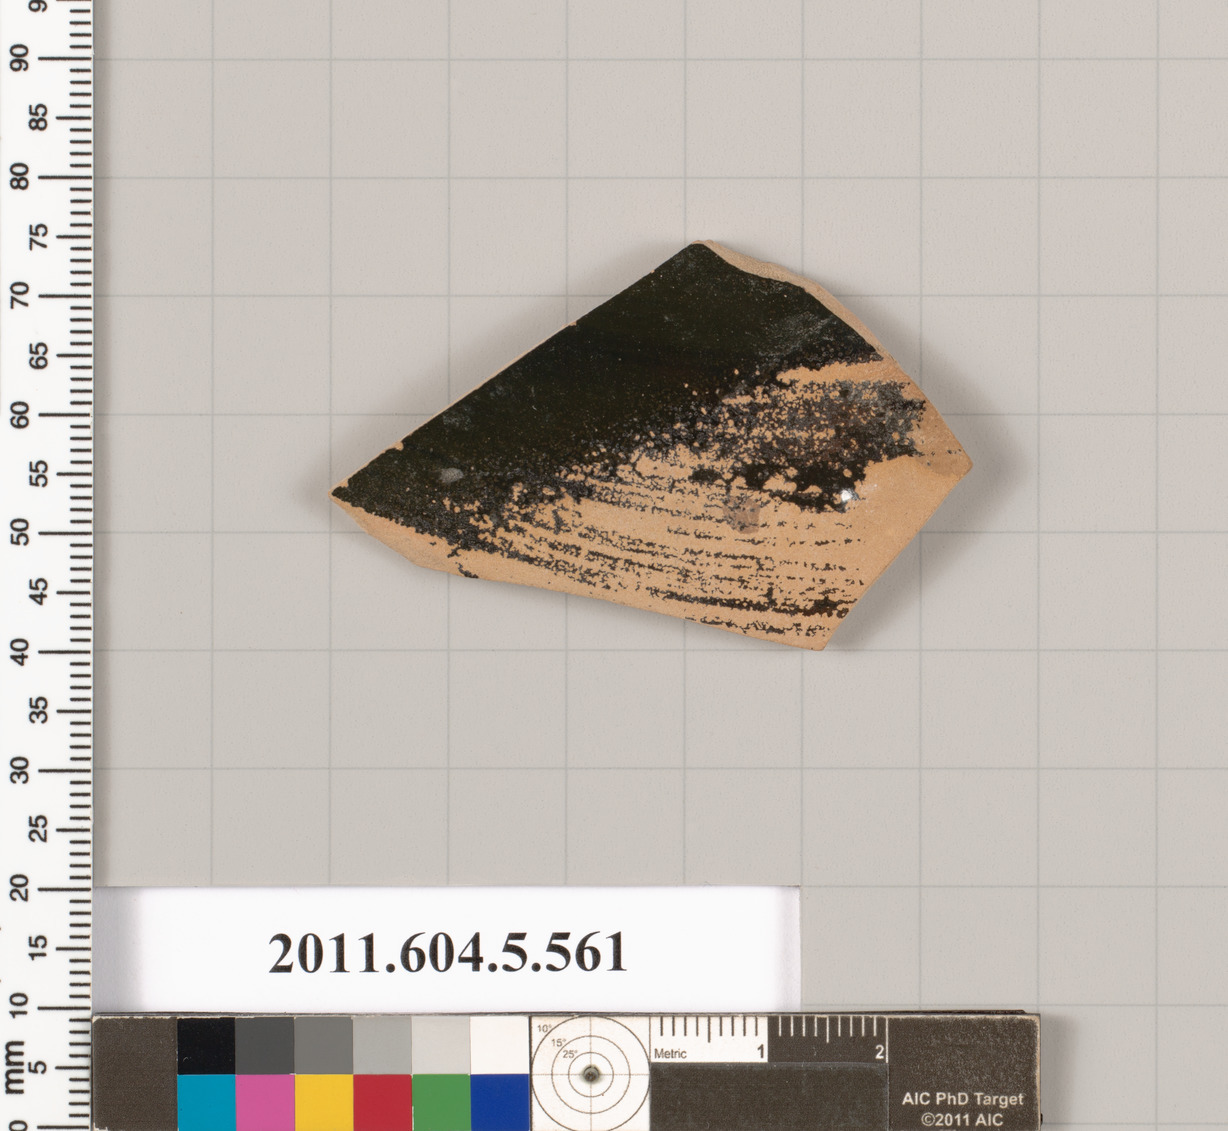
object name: kylix fragment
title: Terracotta fragment of a kylix (drinking cup)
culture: greek, attic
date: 600-401 BCE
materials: terracotta